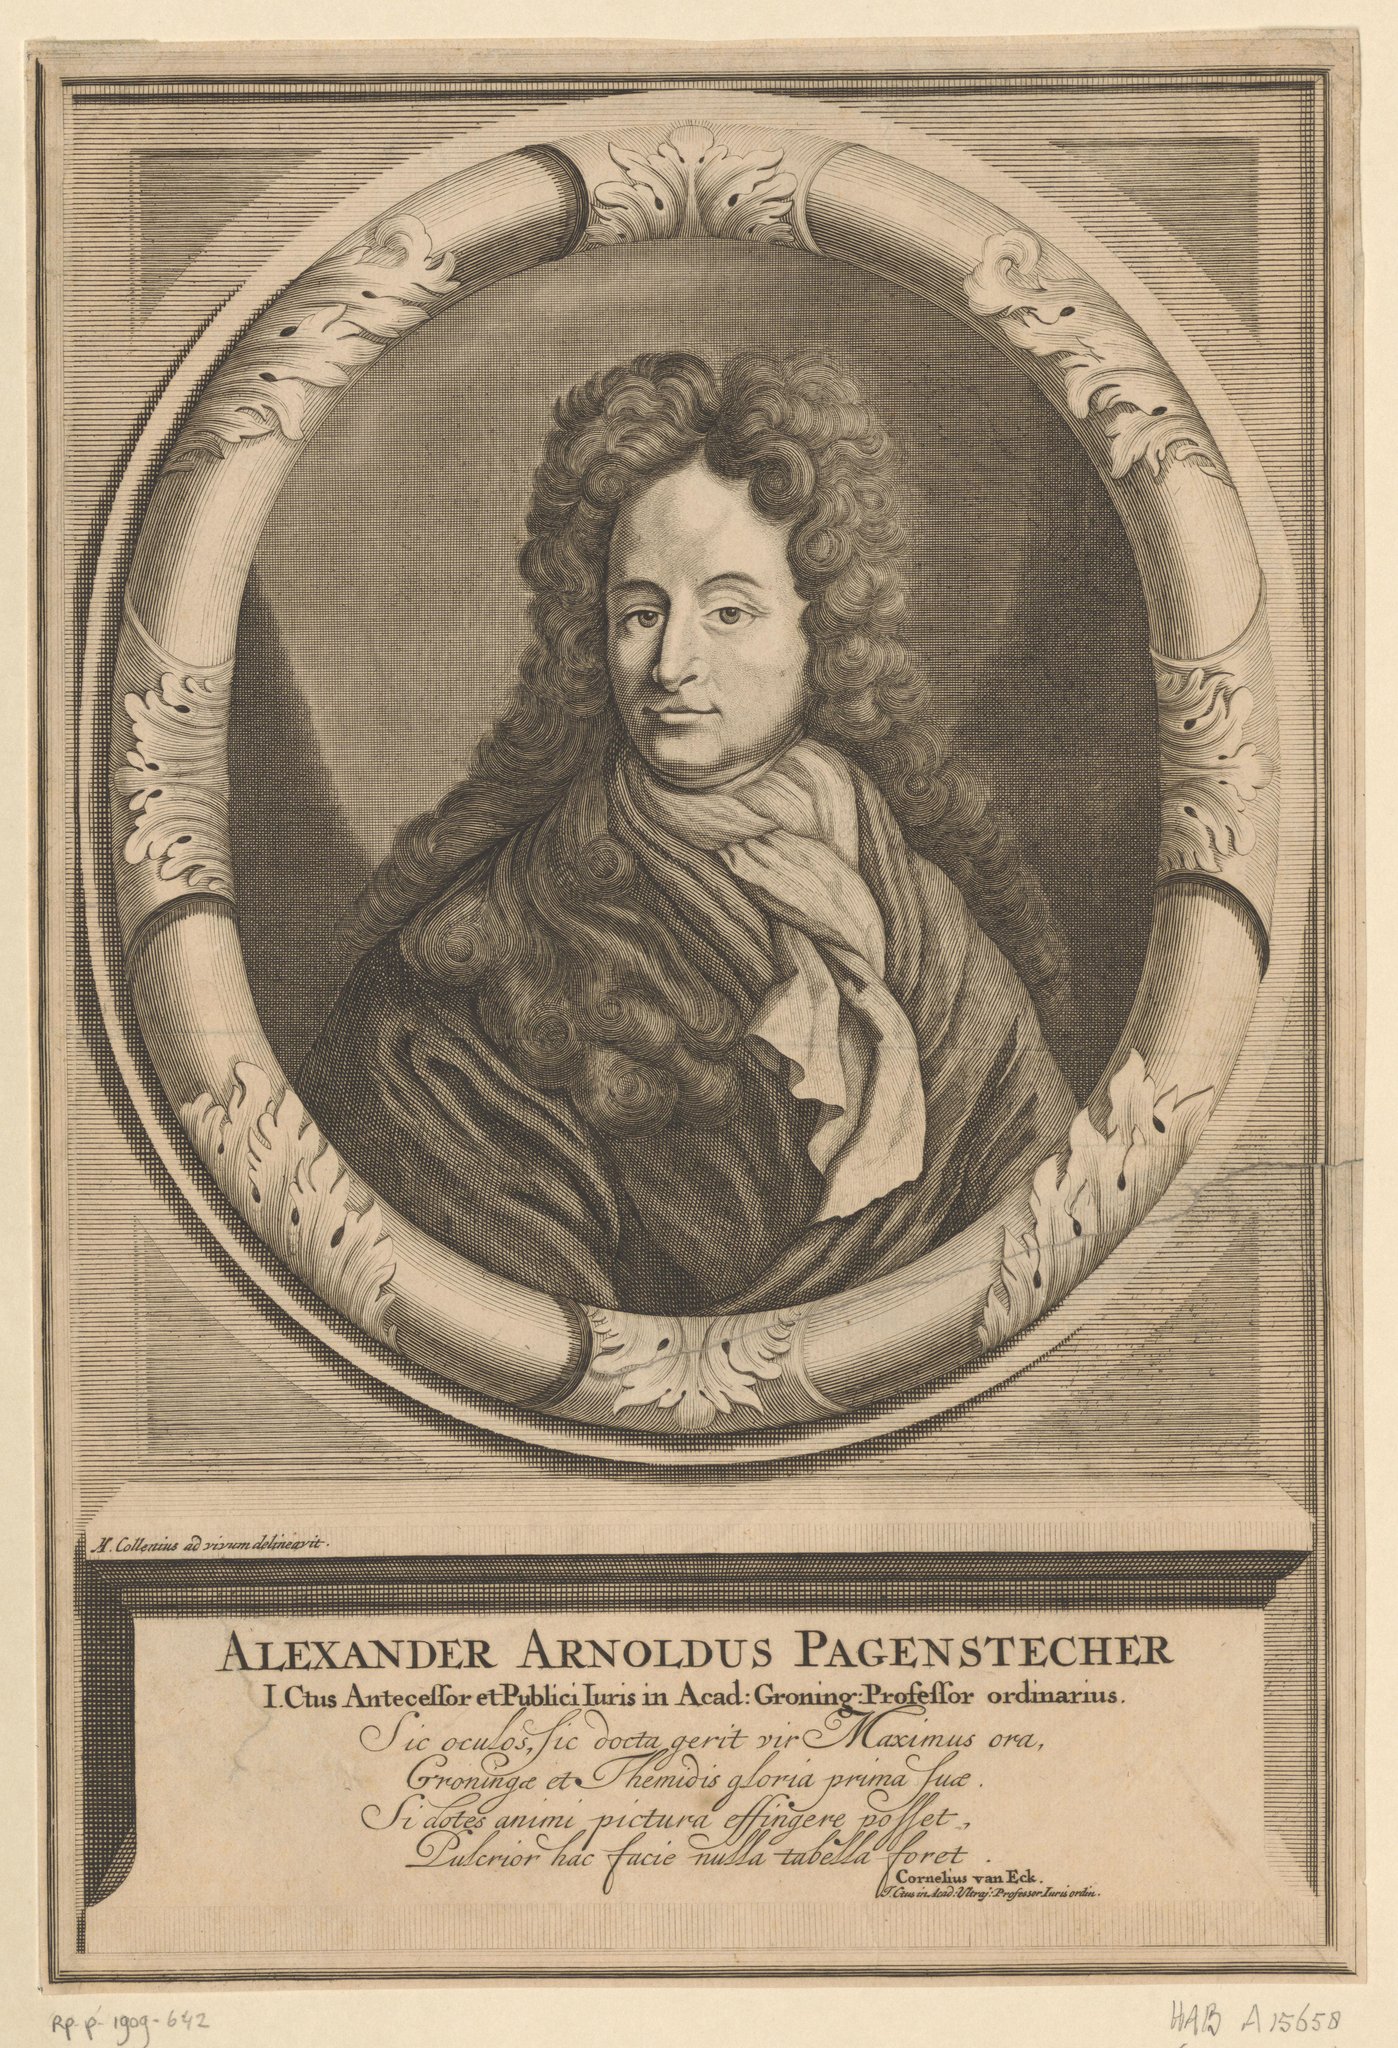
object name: print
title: Portret van Alexander Arnold Pagenstecher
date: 1696-1724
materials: paper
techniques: engraving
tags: adult man, historical persons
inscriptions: collector's mark: Lugt 2228